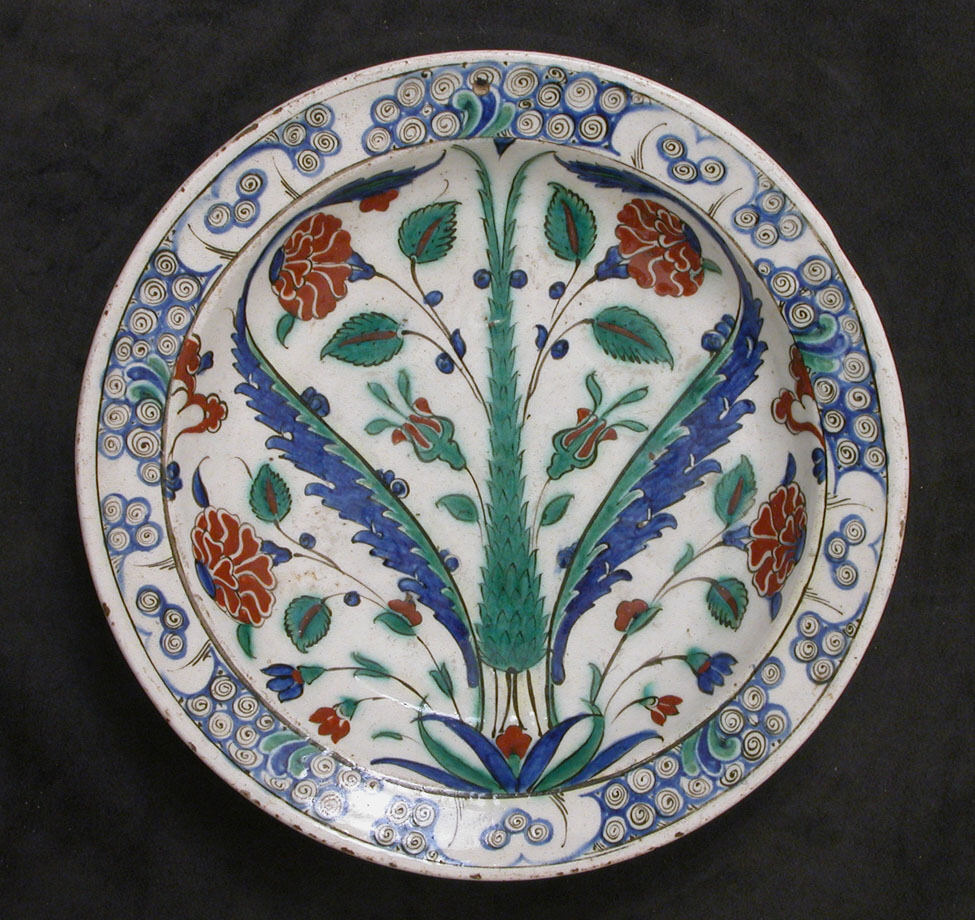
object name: dish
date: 1501-1700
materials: stonepaste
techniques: glazing, painting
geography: turkey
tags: flowers,leaves